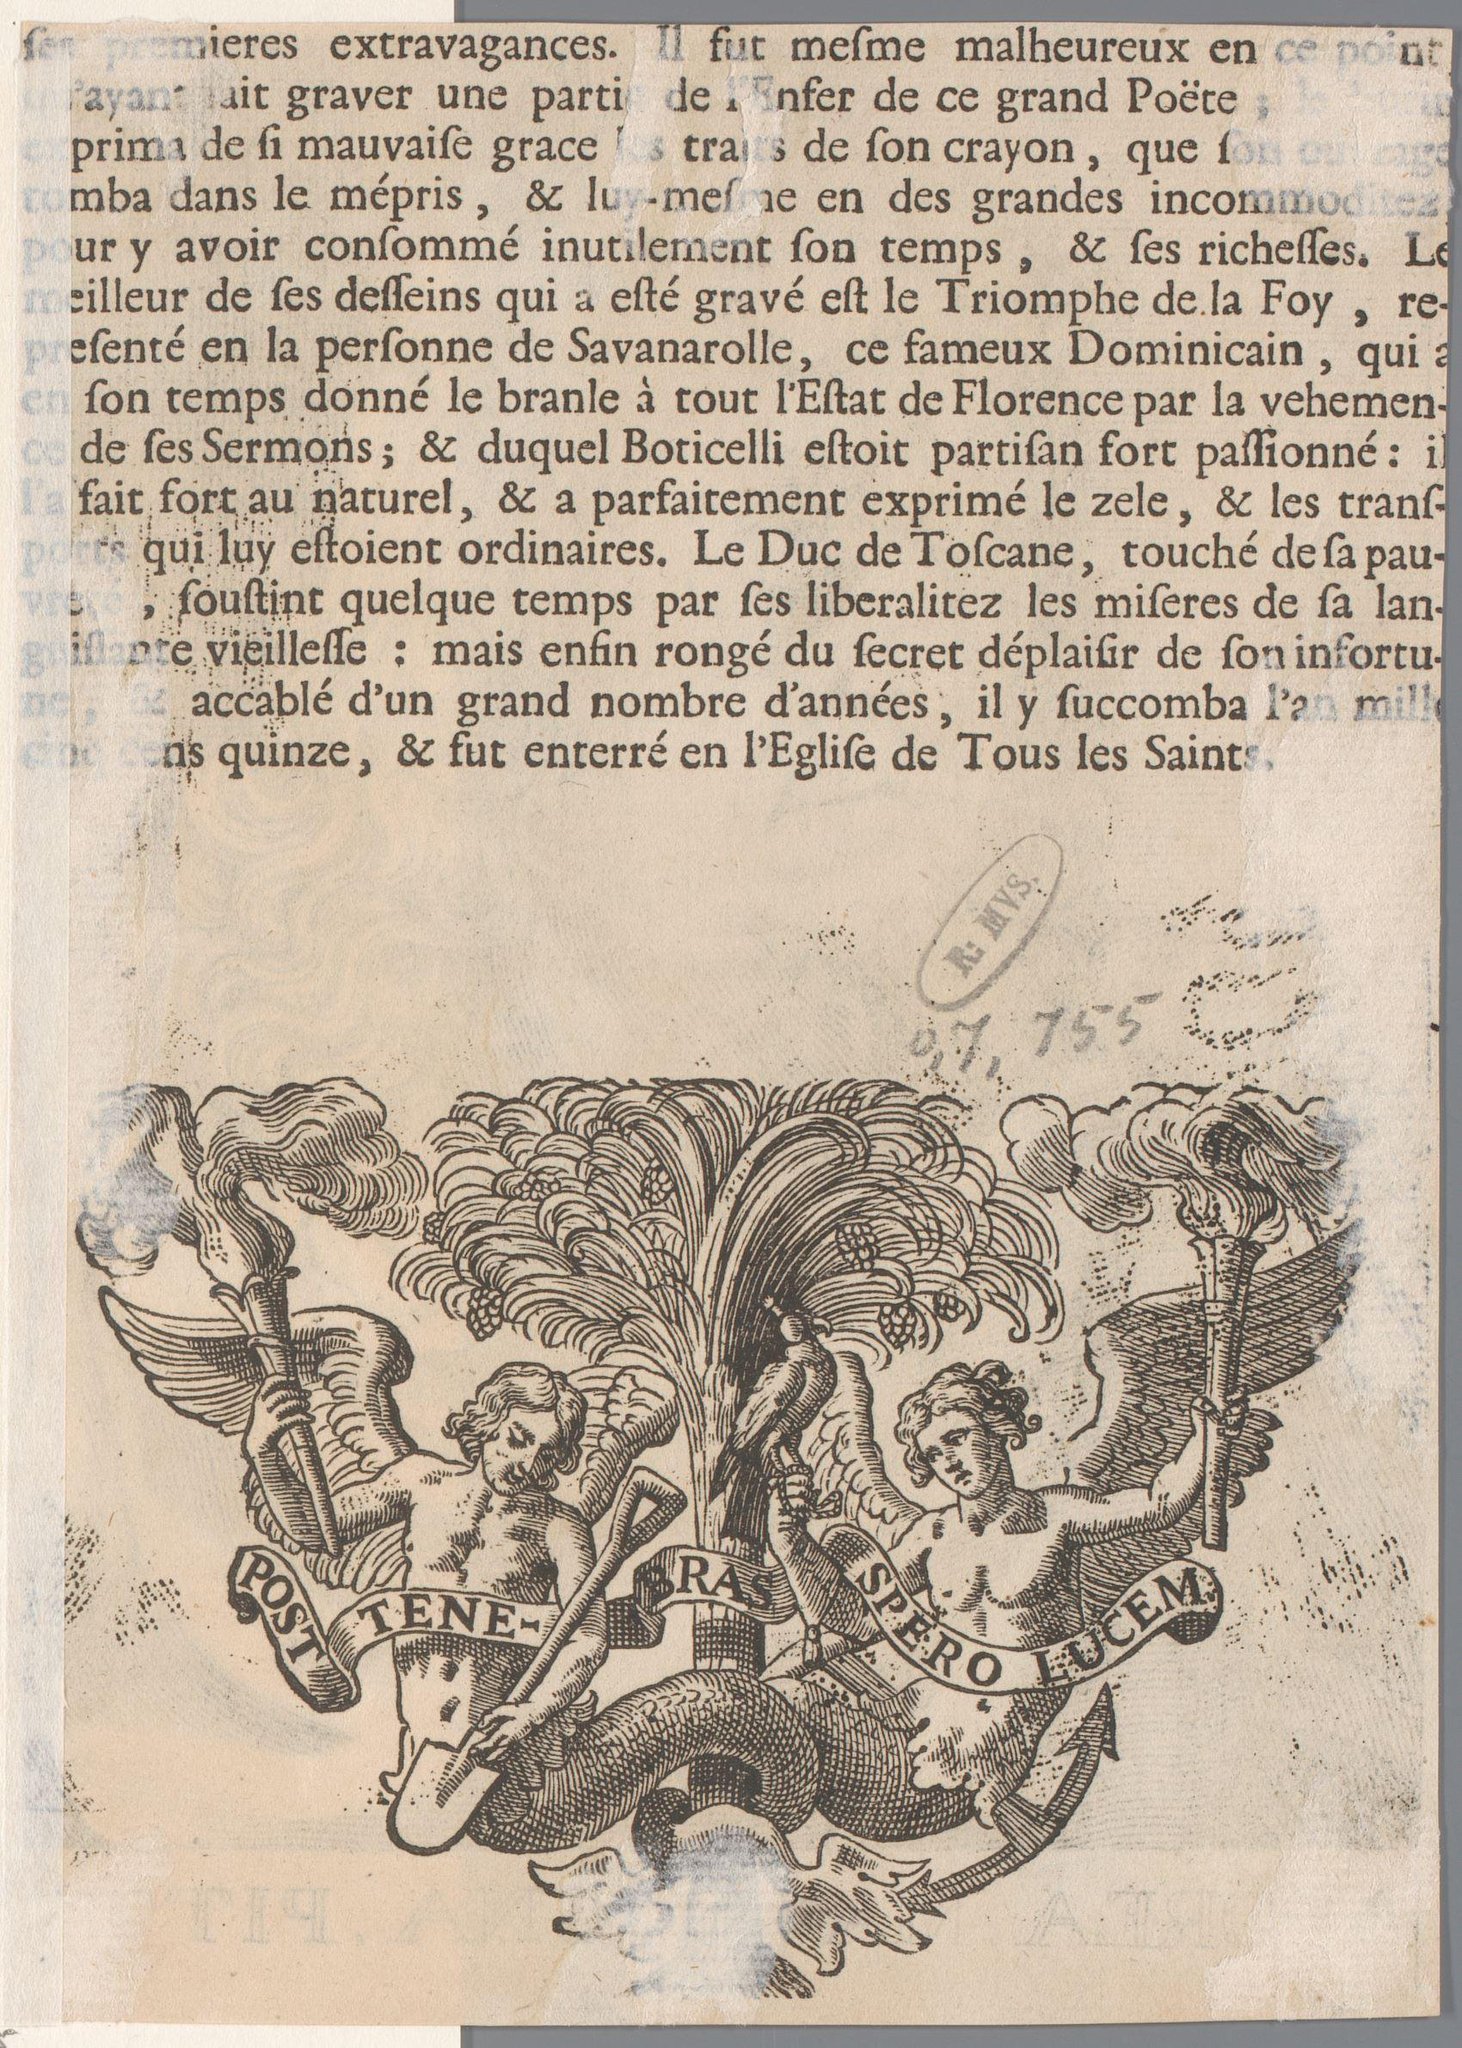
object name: print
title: Drukkersmerk van Jan (I) Mommaert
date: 1682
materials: paper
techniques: letterpress printing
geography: brussels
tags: predatory birds: falcon, triton(s)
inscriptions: collector's mark: Lugt 2228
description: Prent uit: Bullart, Isaac. Académie des Sciences et Arts contenant les vies et éloges his. des hommes illustres qui ont excellé en ces professions depuis environ quatre siècles. Brussel: François Foppens, 1682. Het boek werd in 1682 eveneens in Amsterdam uitgegeven door de erfgenamen van Daniel Elzevier. Ieder portret betreft een illustratie bij de biografie van een kunstenaar of geleerde. De meeste portretten werden door Nicolas de Larmessin vervaardigd (162), 93 door De Boulonois en een derde door ongeïdentificeerde prentmakers.